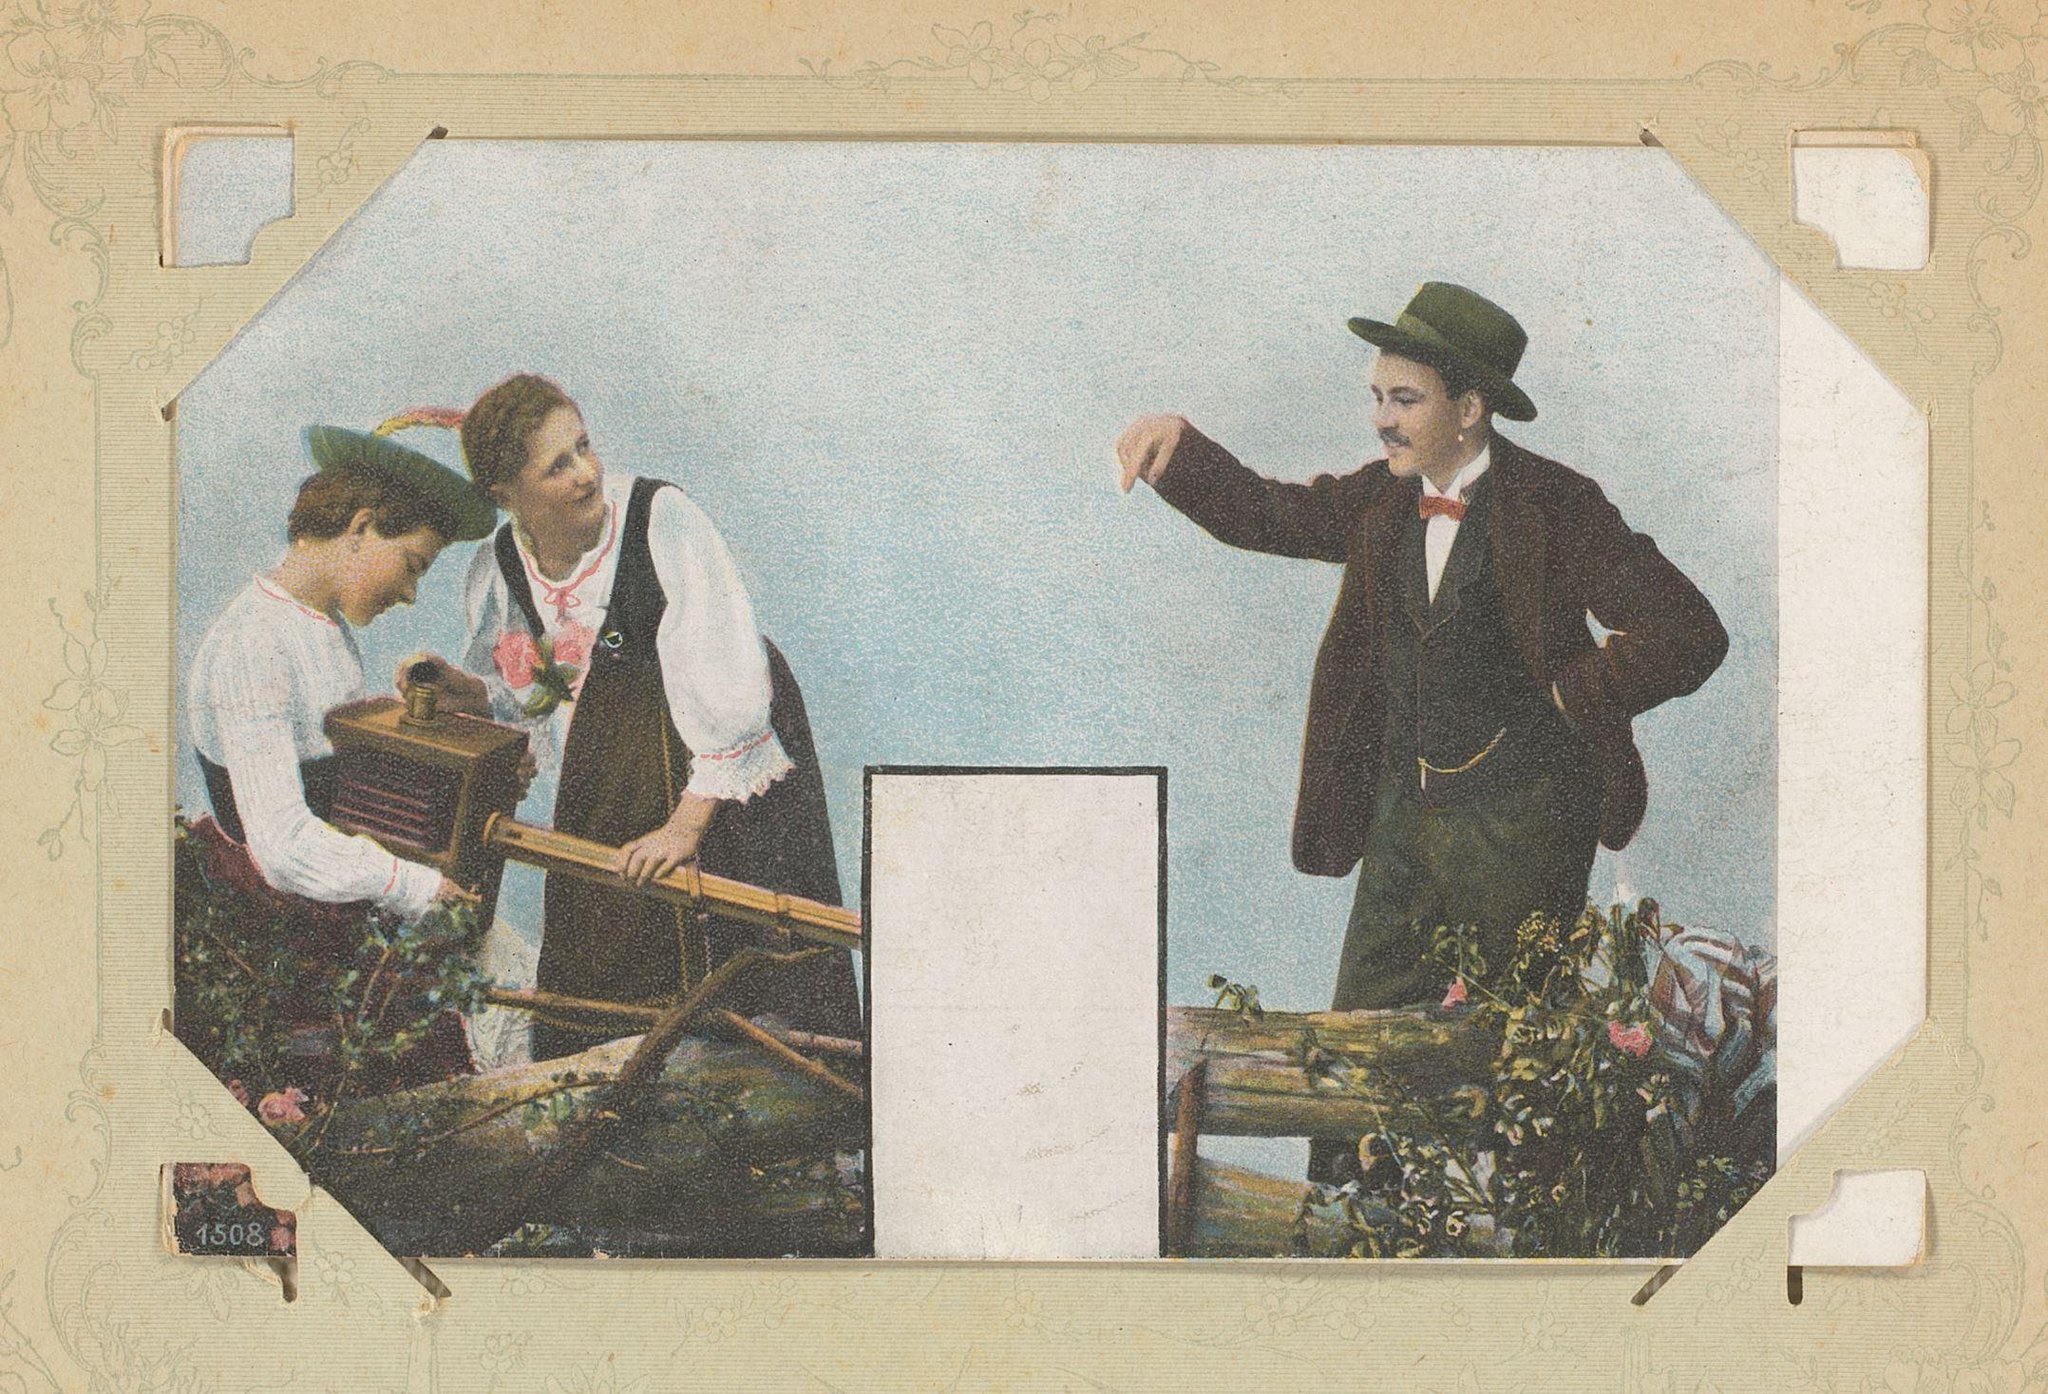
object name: ansichtkaart, prentbriefkaart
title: Twee vrouwen en een man met camera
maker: Anonymous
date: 1900-1950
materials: cardboard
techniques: four-color autotype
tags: flowers, adult woman, photography, adult man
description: Deze prent maakt deel uit van een album.